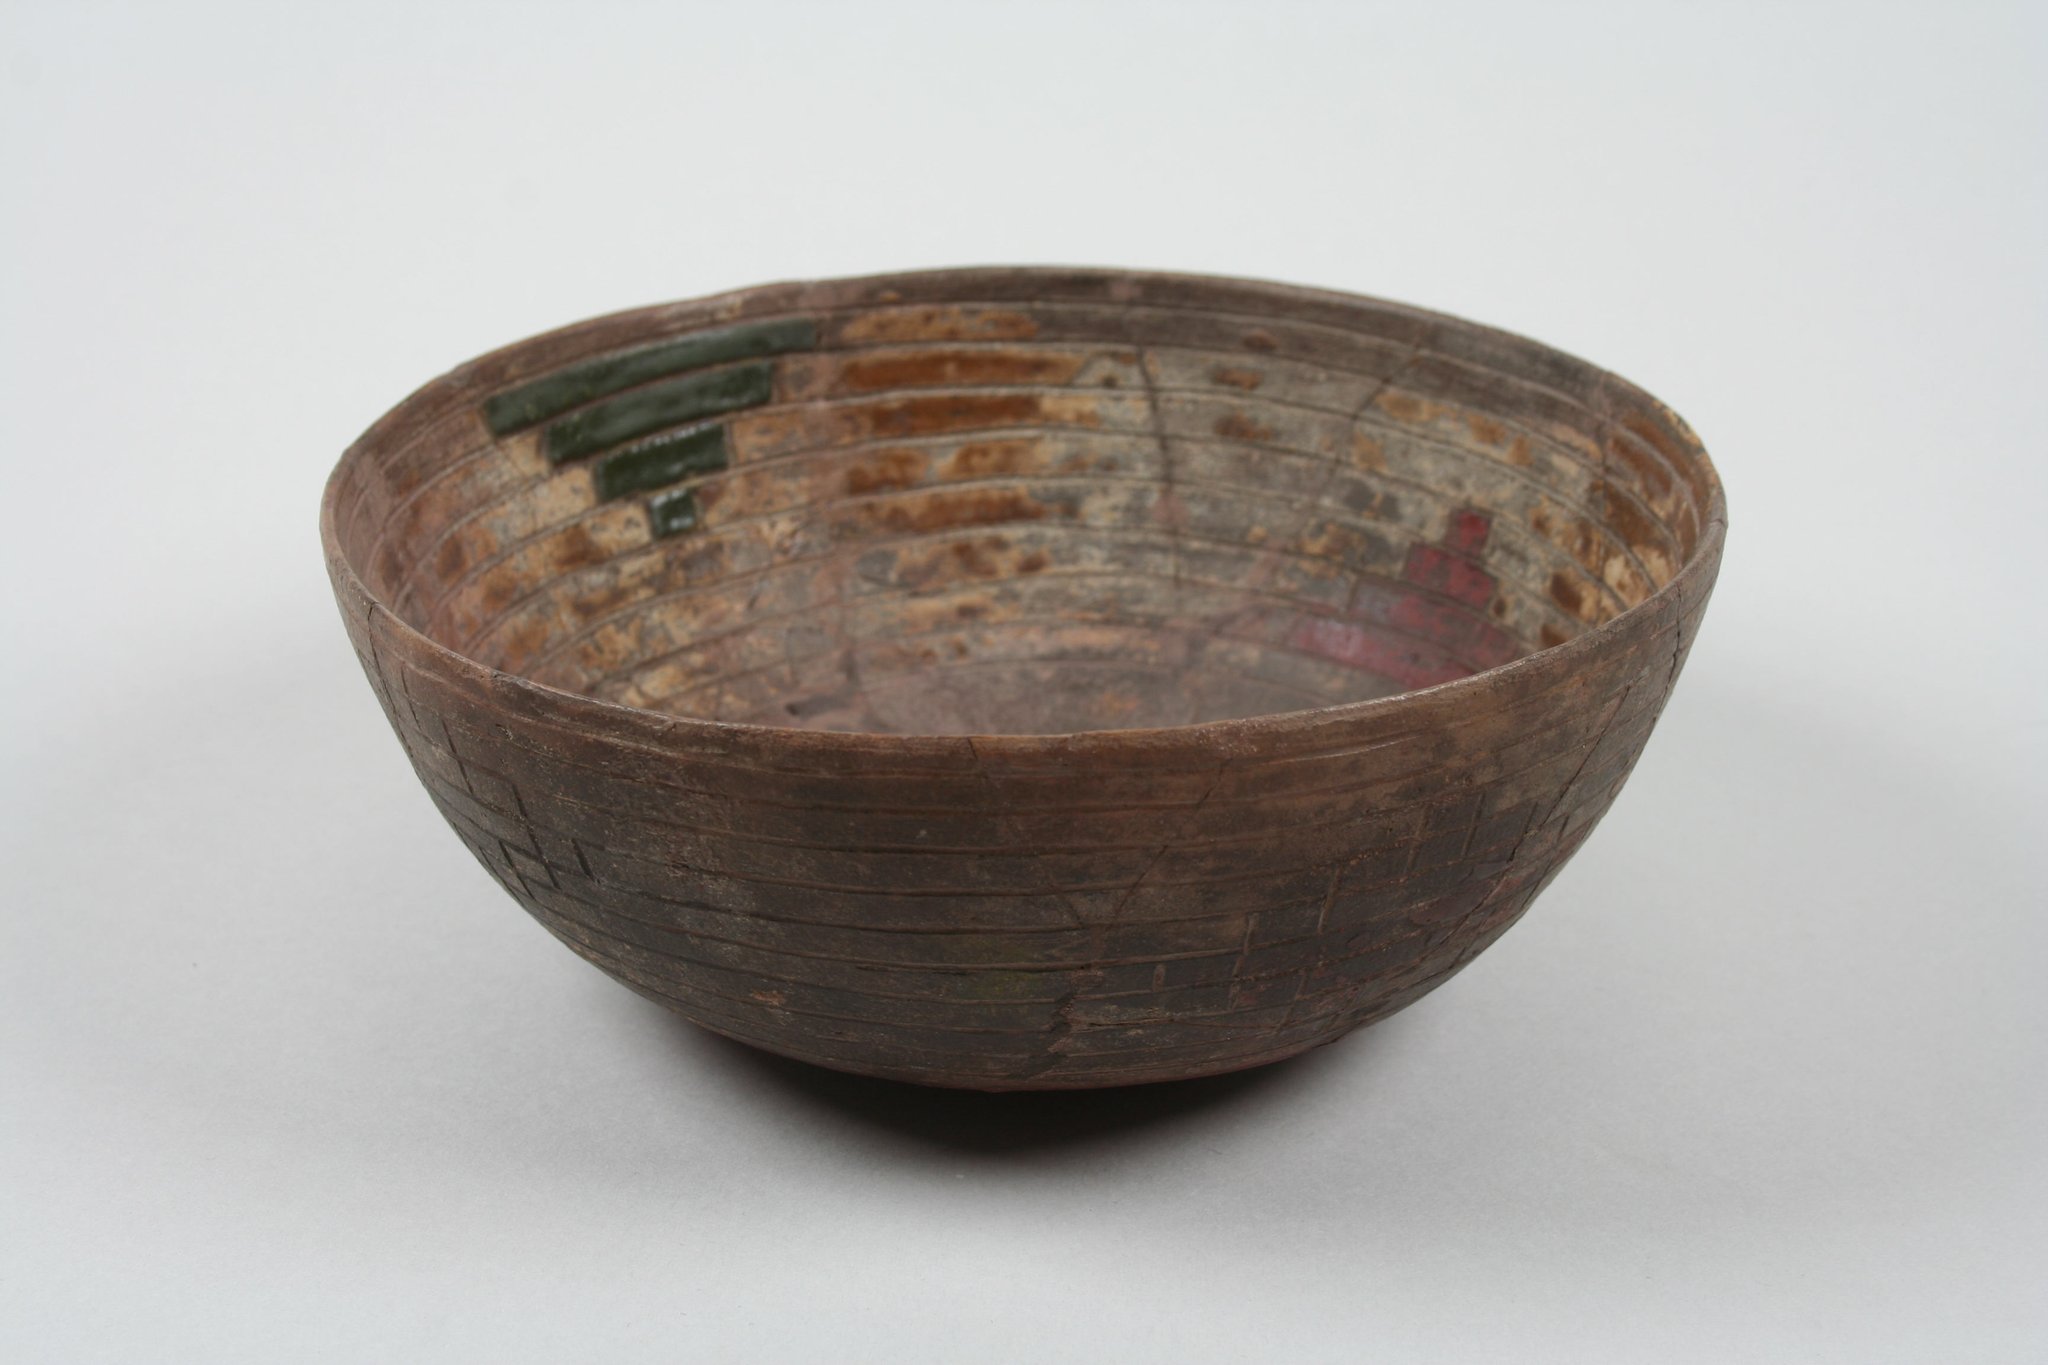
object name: bowl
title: Greyware Bowl with Incised Designs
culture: paracas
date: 300-201 BCE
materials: ceramic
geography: peru